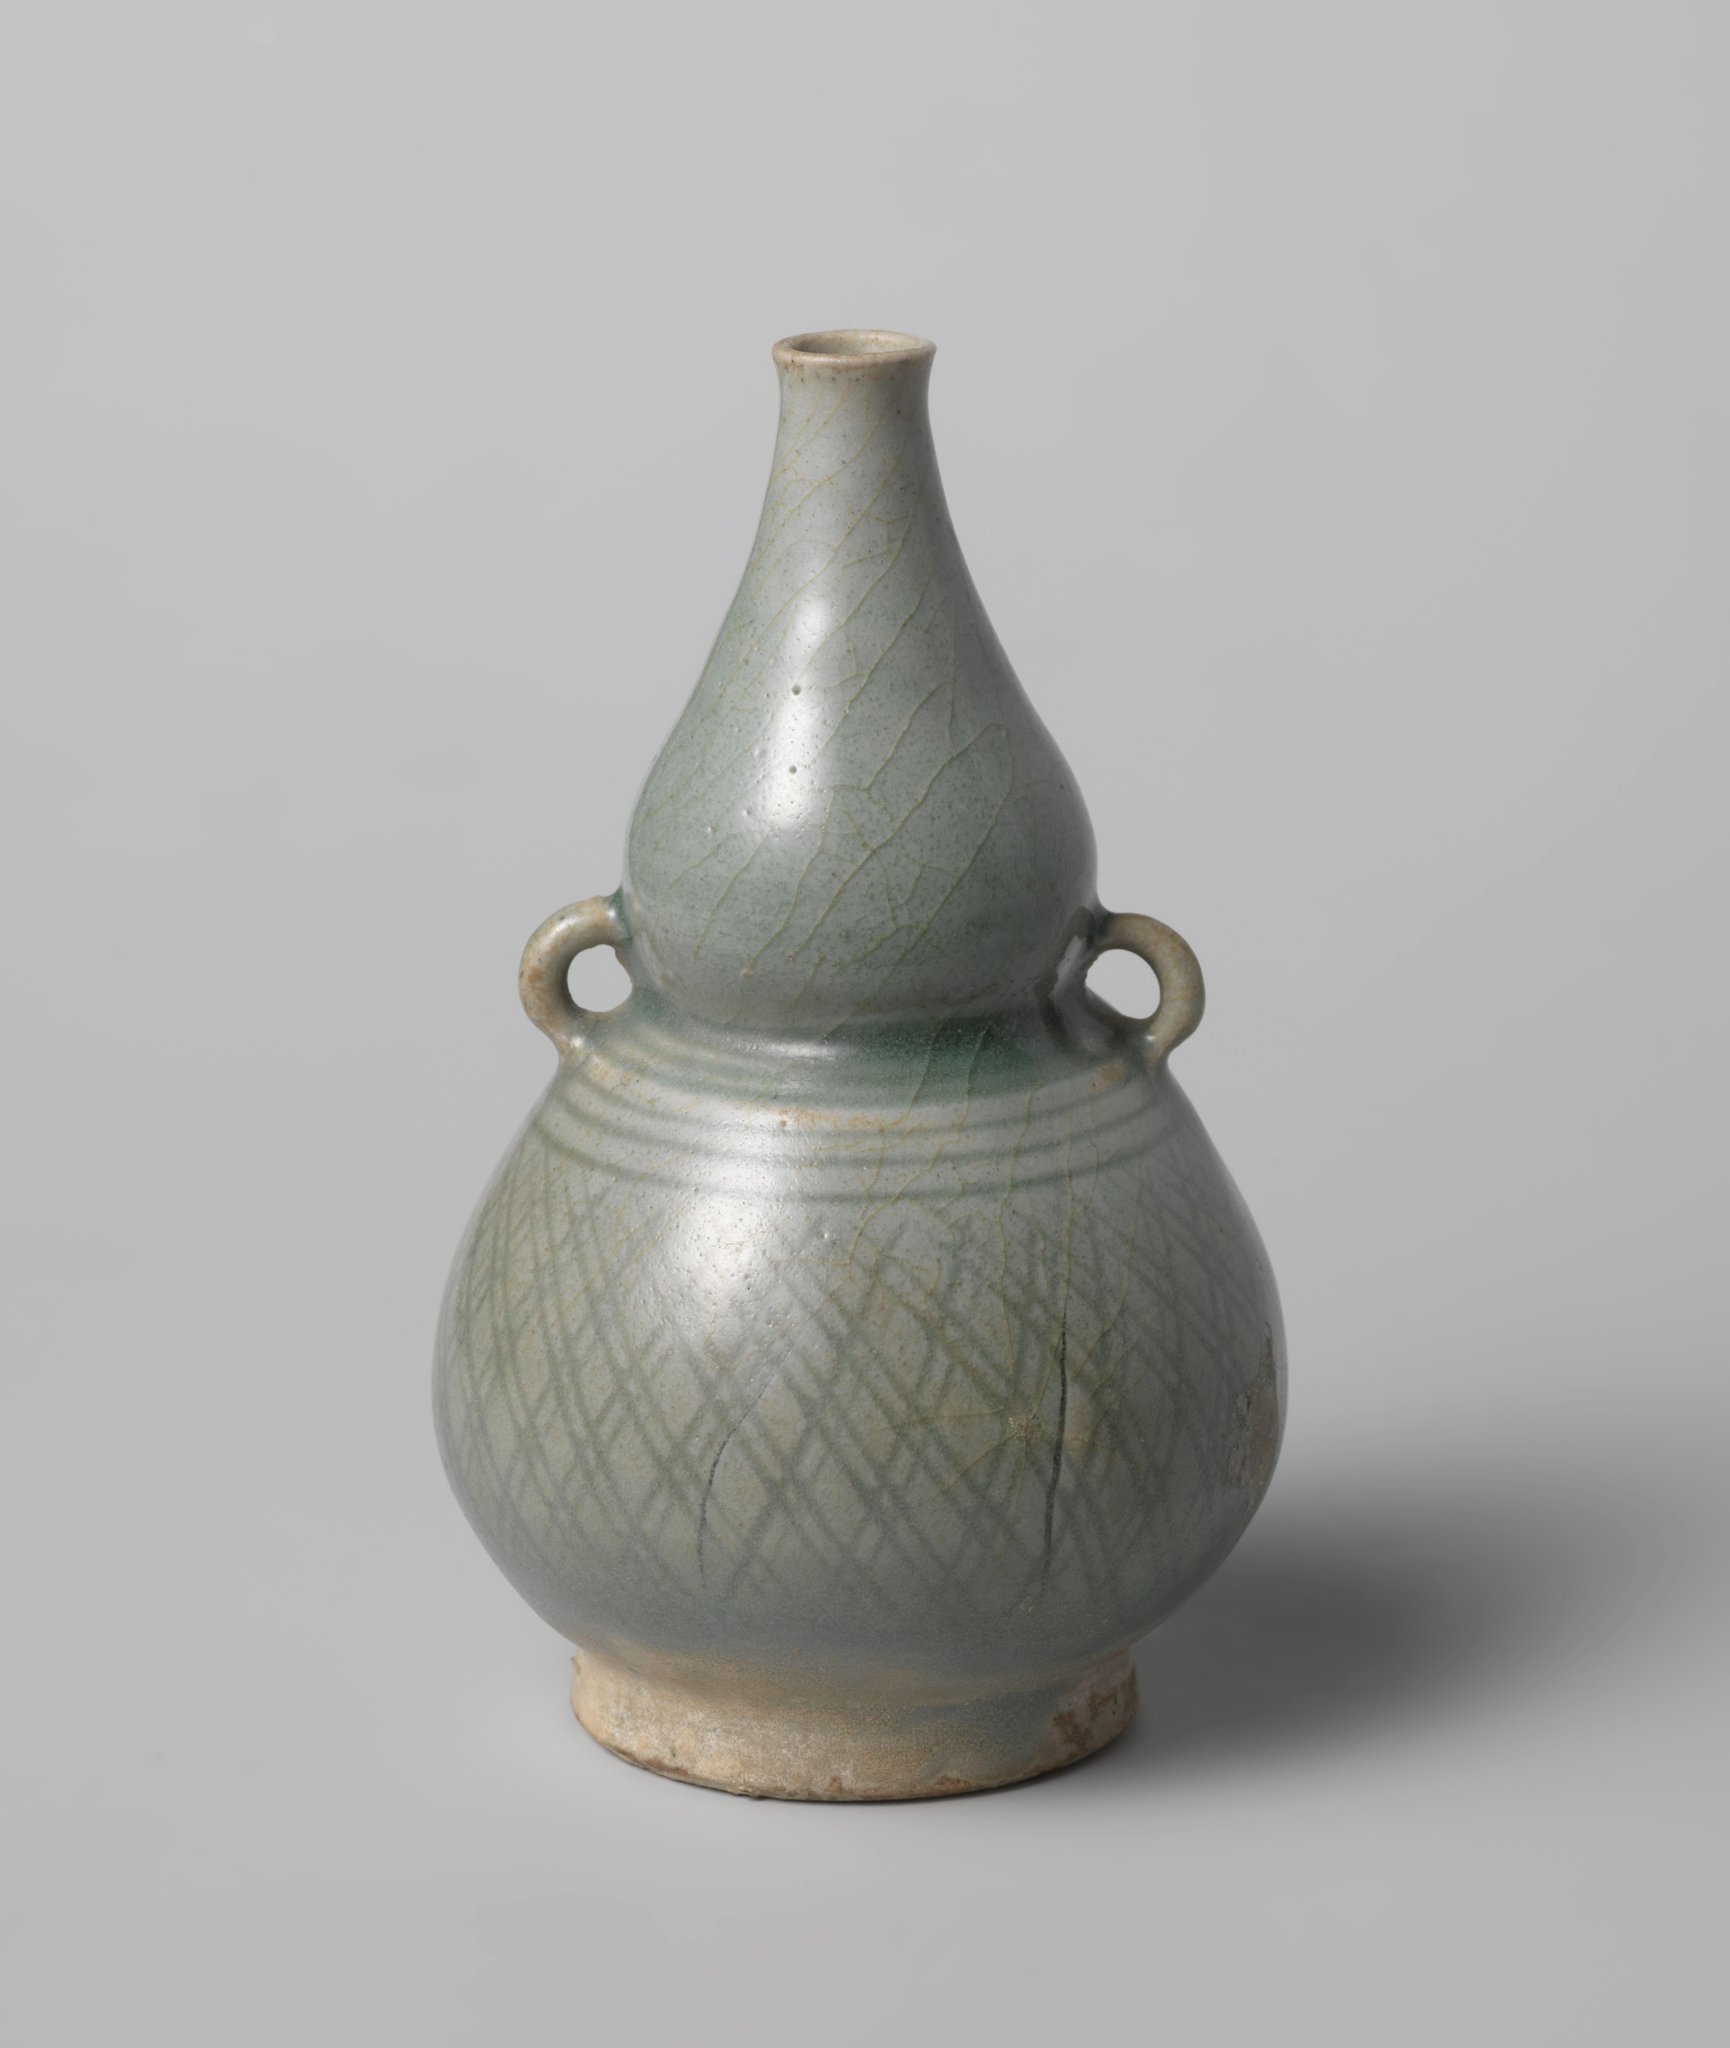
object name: vase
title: Double gourd-shaped vase with two handles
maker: Anonymous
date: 1200-1399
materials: glaze, paint, stoneware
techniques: firing, turning, vitrification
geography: sawankhalok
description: Kalebasvormige vaas van steengoed, bedekt met een groen glazuur. Het onderste deel met ingegrift arceerwerk en drie horizontale lijnen. Twee kleine, halfronde oren vanuit het onderste deel naar het bovenste. Celadon.